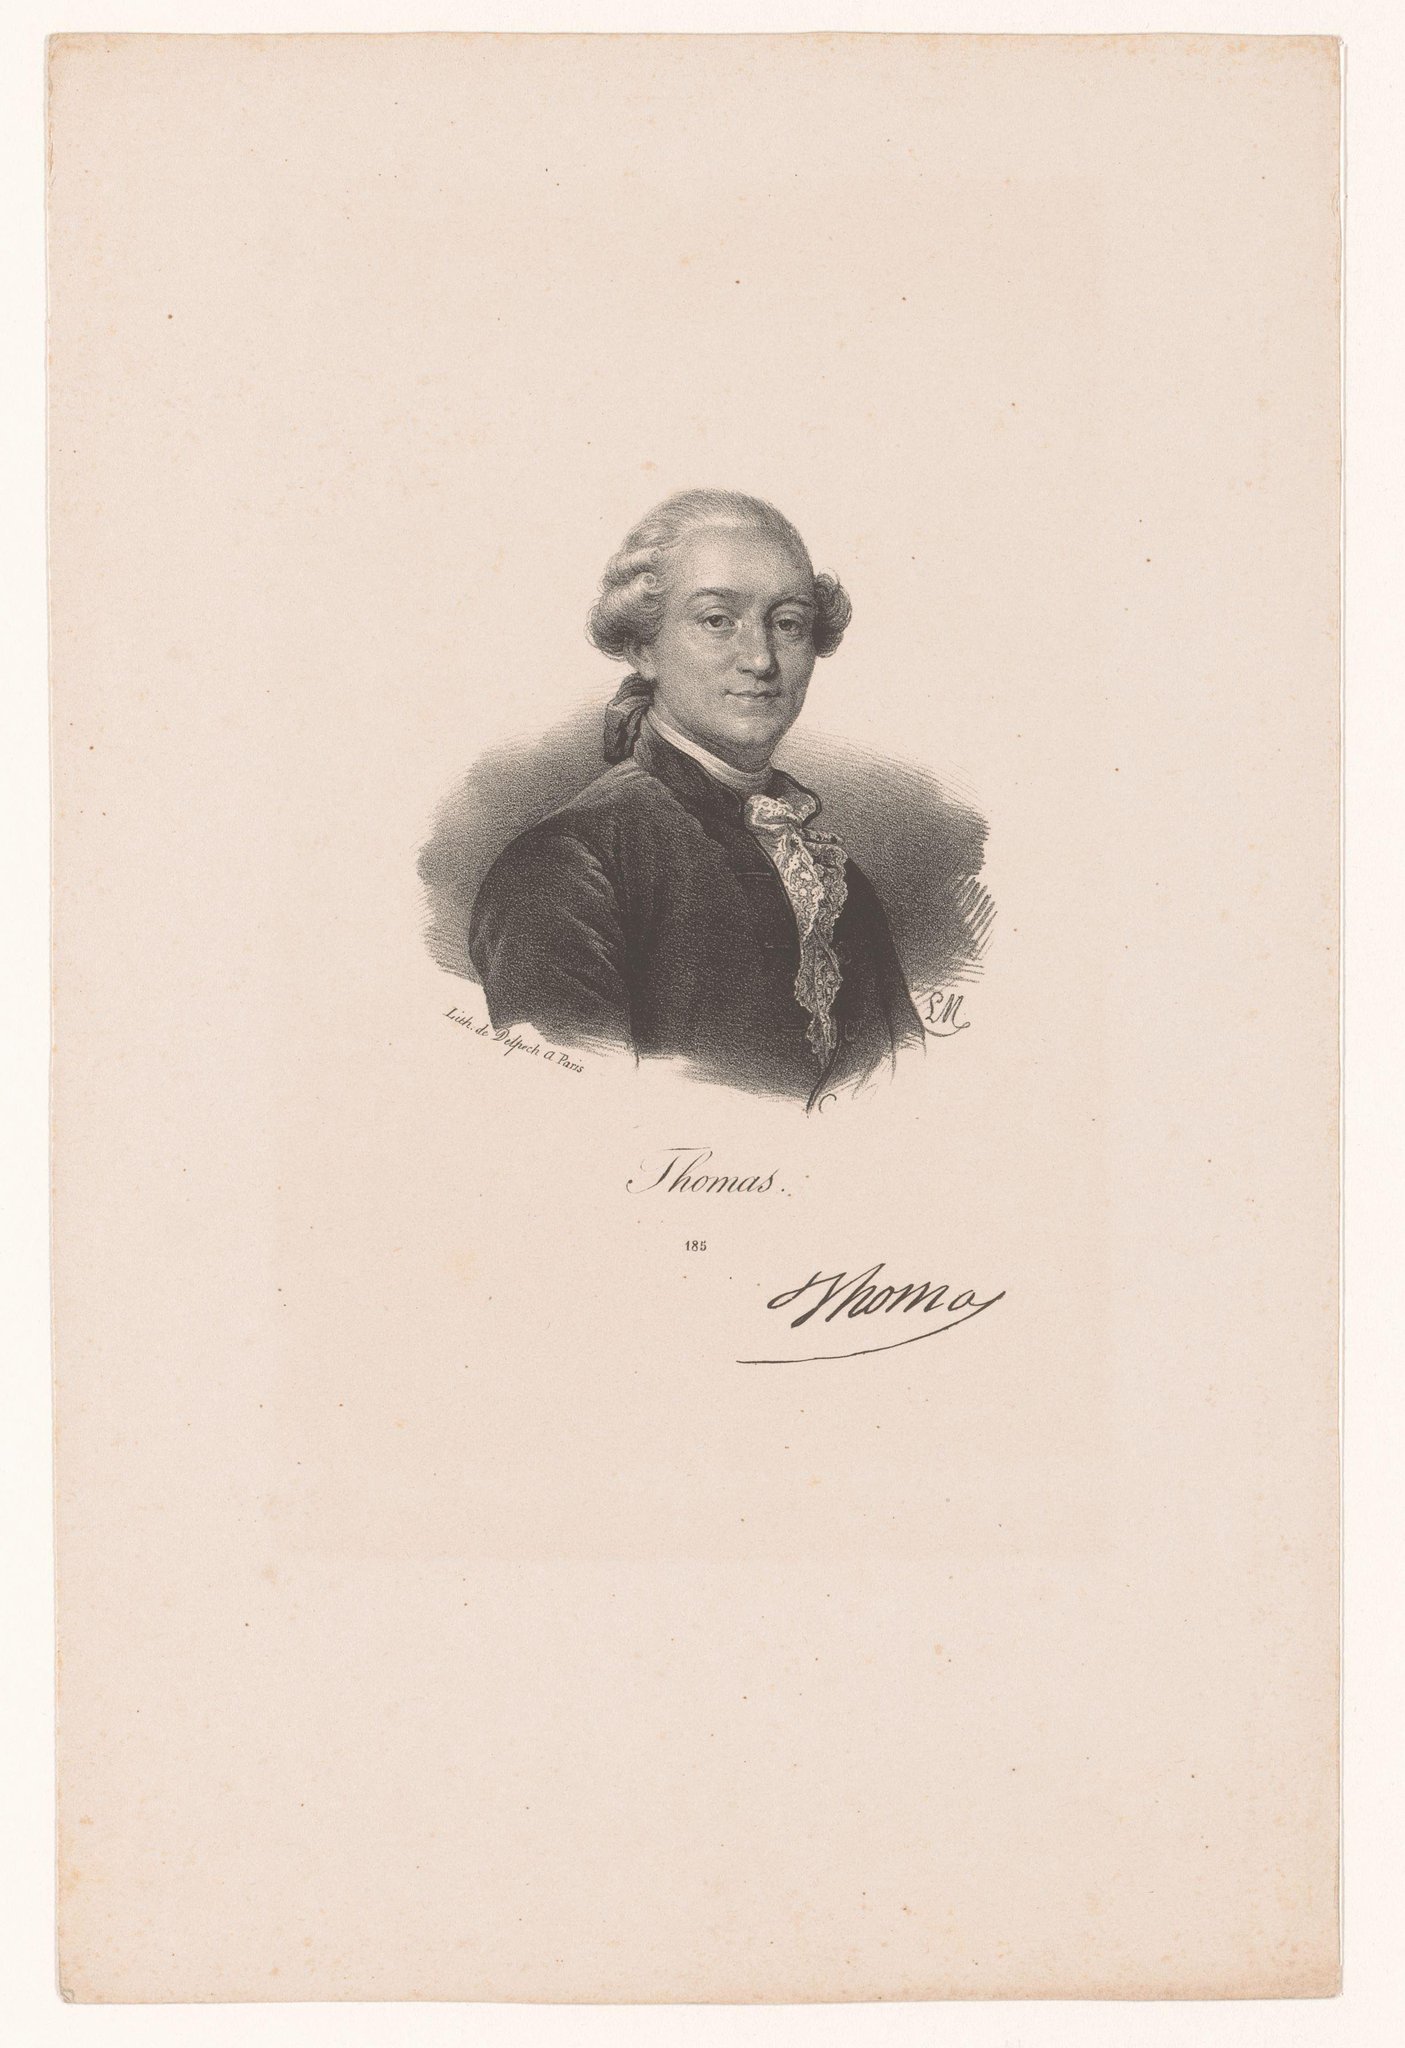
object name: print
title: Portret van schrijver Antoine Léonard Thomas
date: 1825-1842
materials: paper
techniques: lithograph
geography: paris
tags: historical persons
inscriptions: collector's mark: Lugt 2228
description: Prent waarschijnlijk gebruikt voor: Iconographie française ou recueil des portraits des personnages les plus illustres qui ont paru en France depuis François premier jusqu'à la fin du règne de Louis XVI (…). Parijs: veuve Delpech, 1828. En/of voor: Iconographie française ou choix de deux cents portraits d'hommes et de femmes qui se sont acquis en France, depuis le règne de Charles VII jusqu'à la fin de celui de Louis XVI (…). Parijs: veuve Delpech, 1840. Mogelijk komt de prent ook voor in eerdere en/of latere publicaties uitgegeven door veuve Delpech of haar opvolger Rosselin.